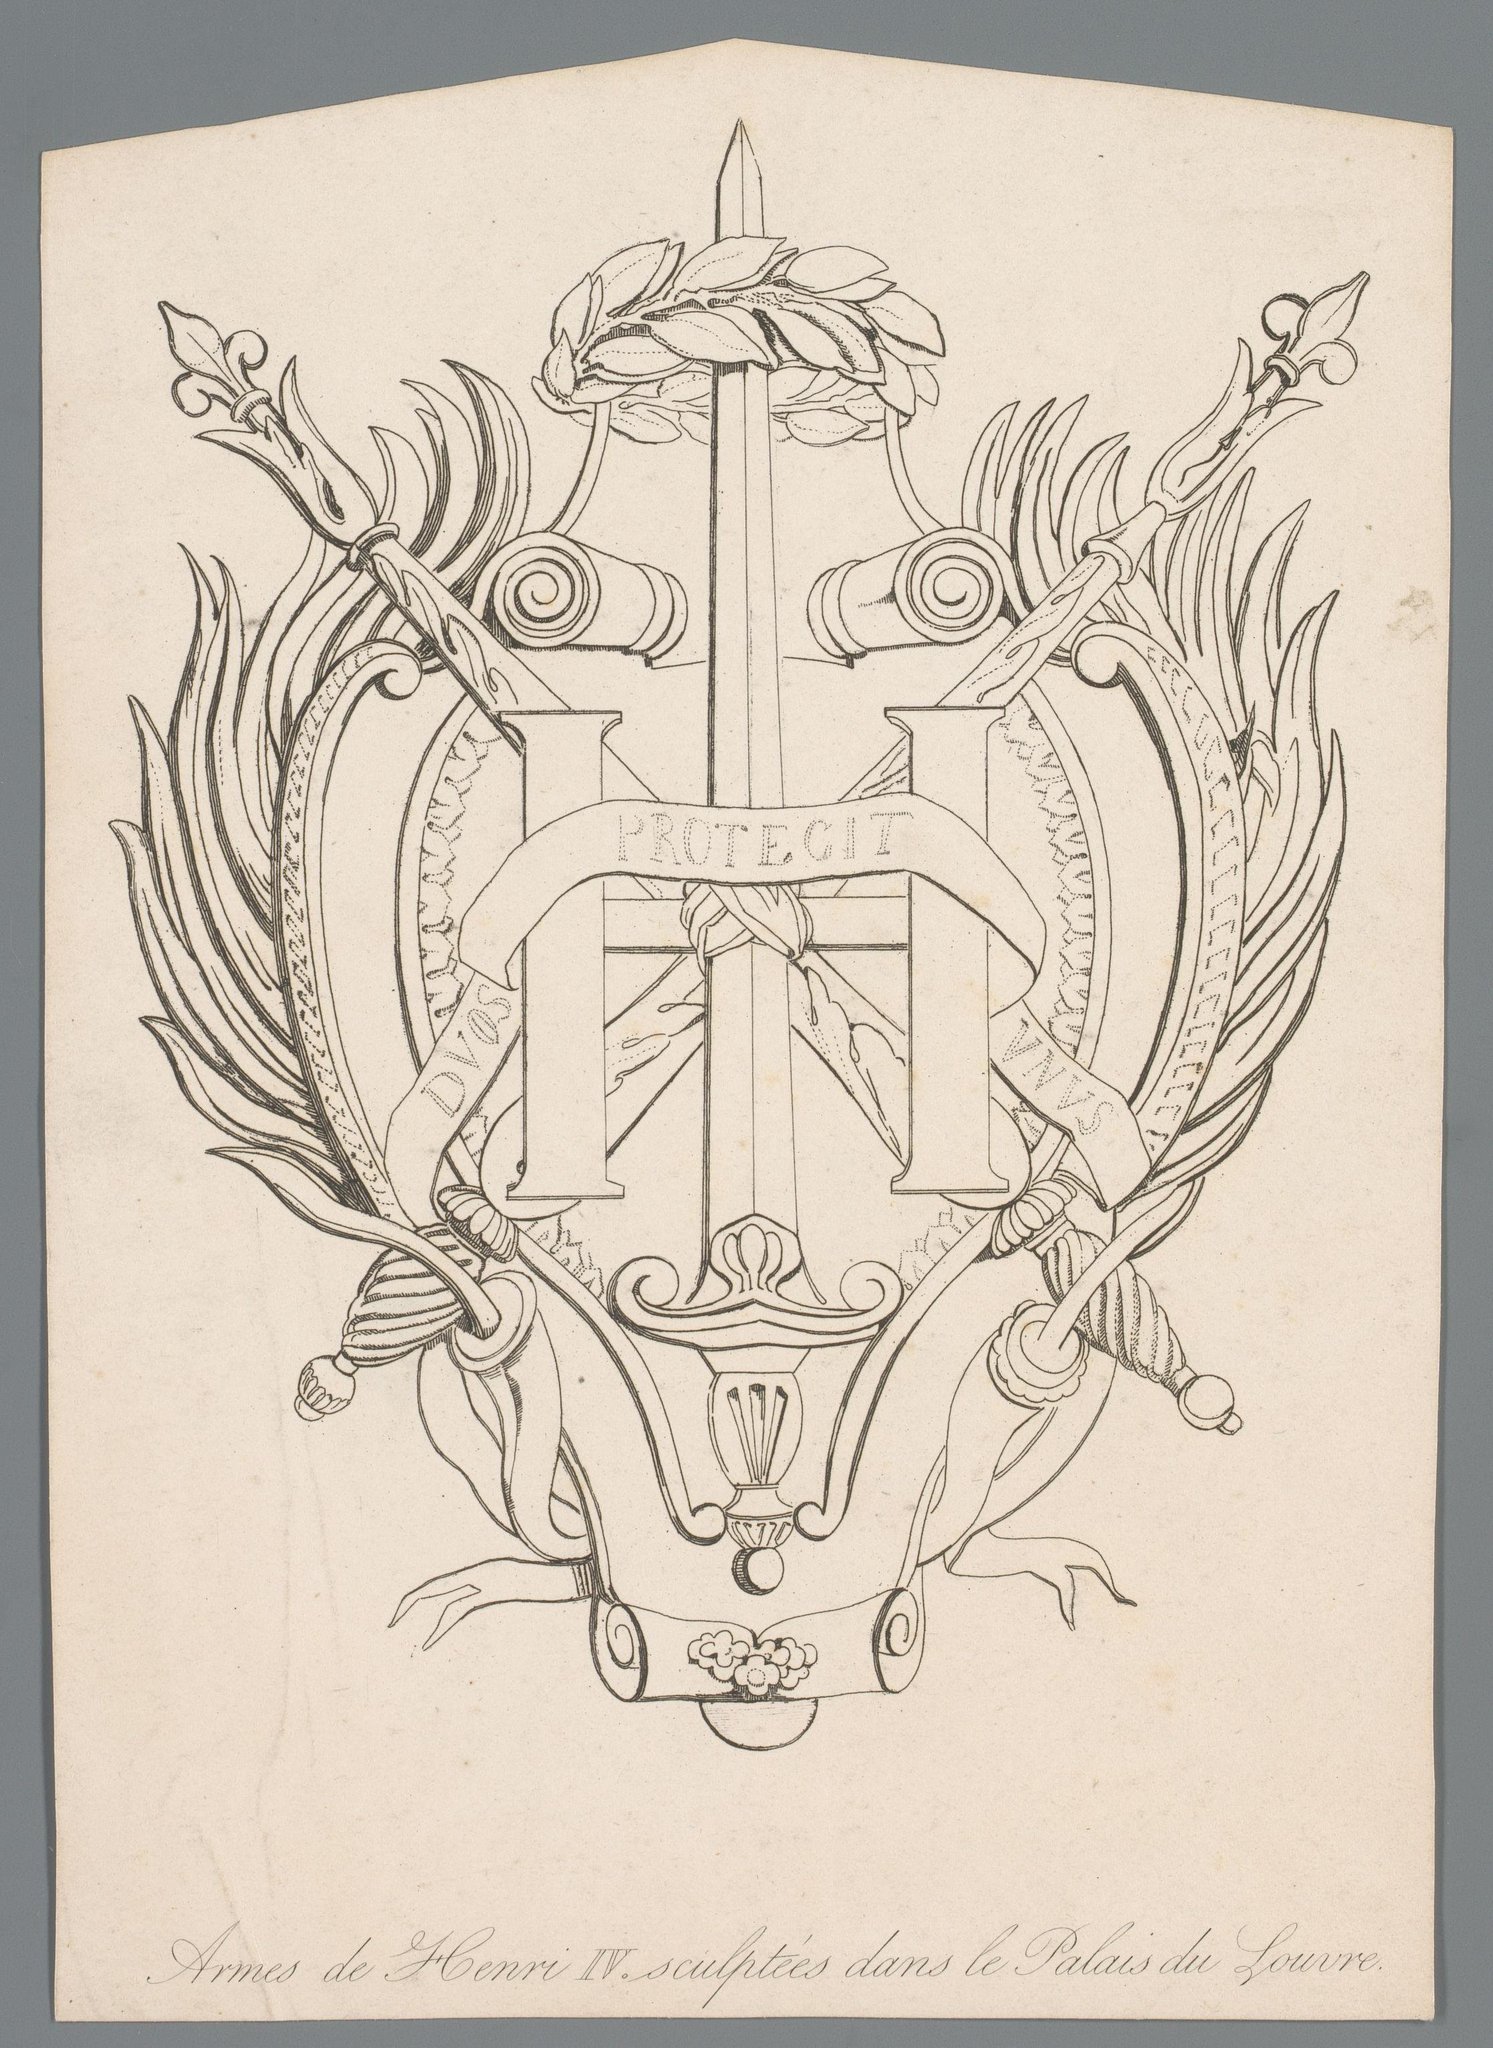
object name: print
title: Armes de Henri IV sculptées dans le Palais du Louvre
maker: Anonymous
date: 1800-1849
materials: paper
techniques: etching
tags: paris, hendrik iv (koning van frankrijk en navarra), garland, wreath